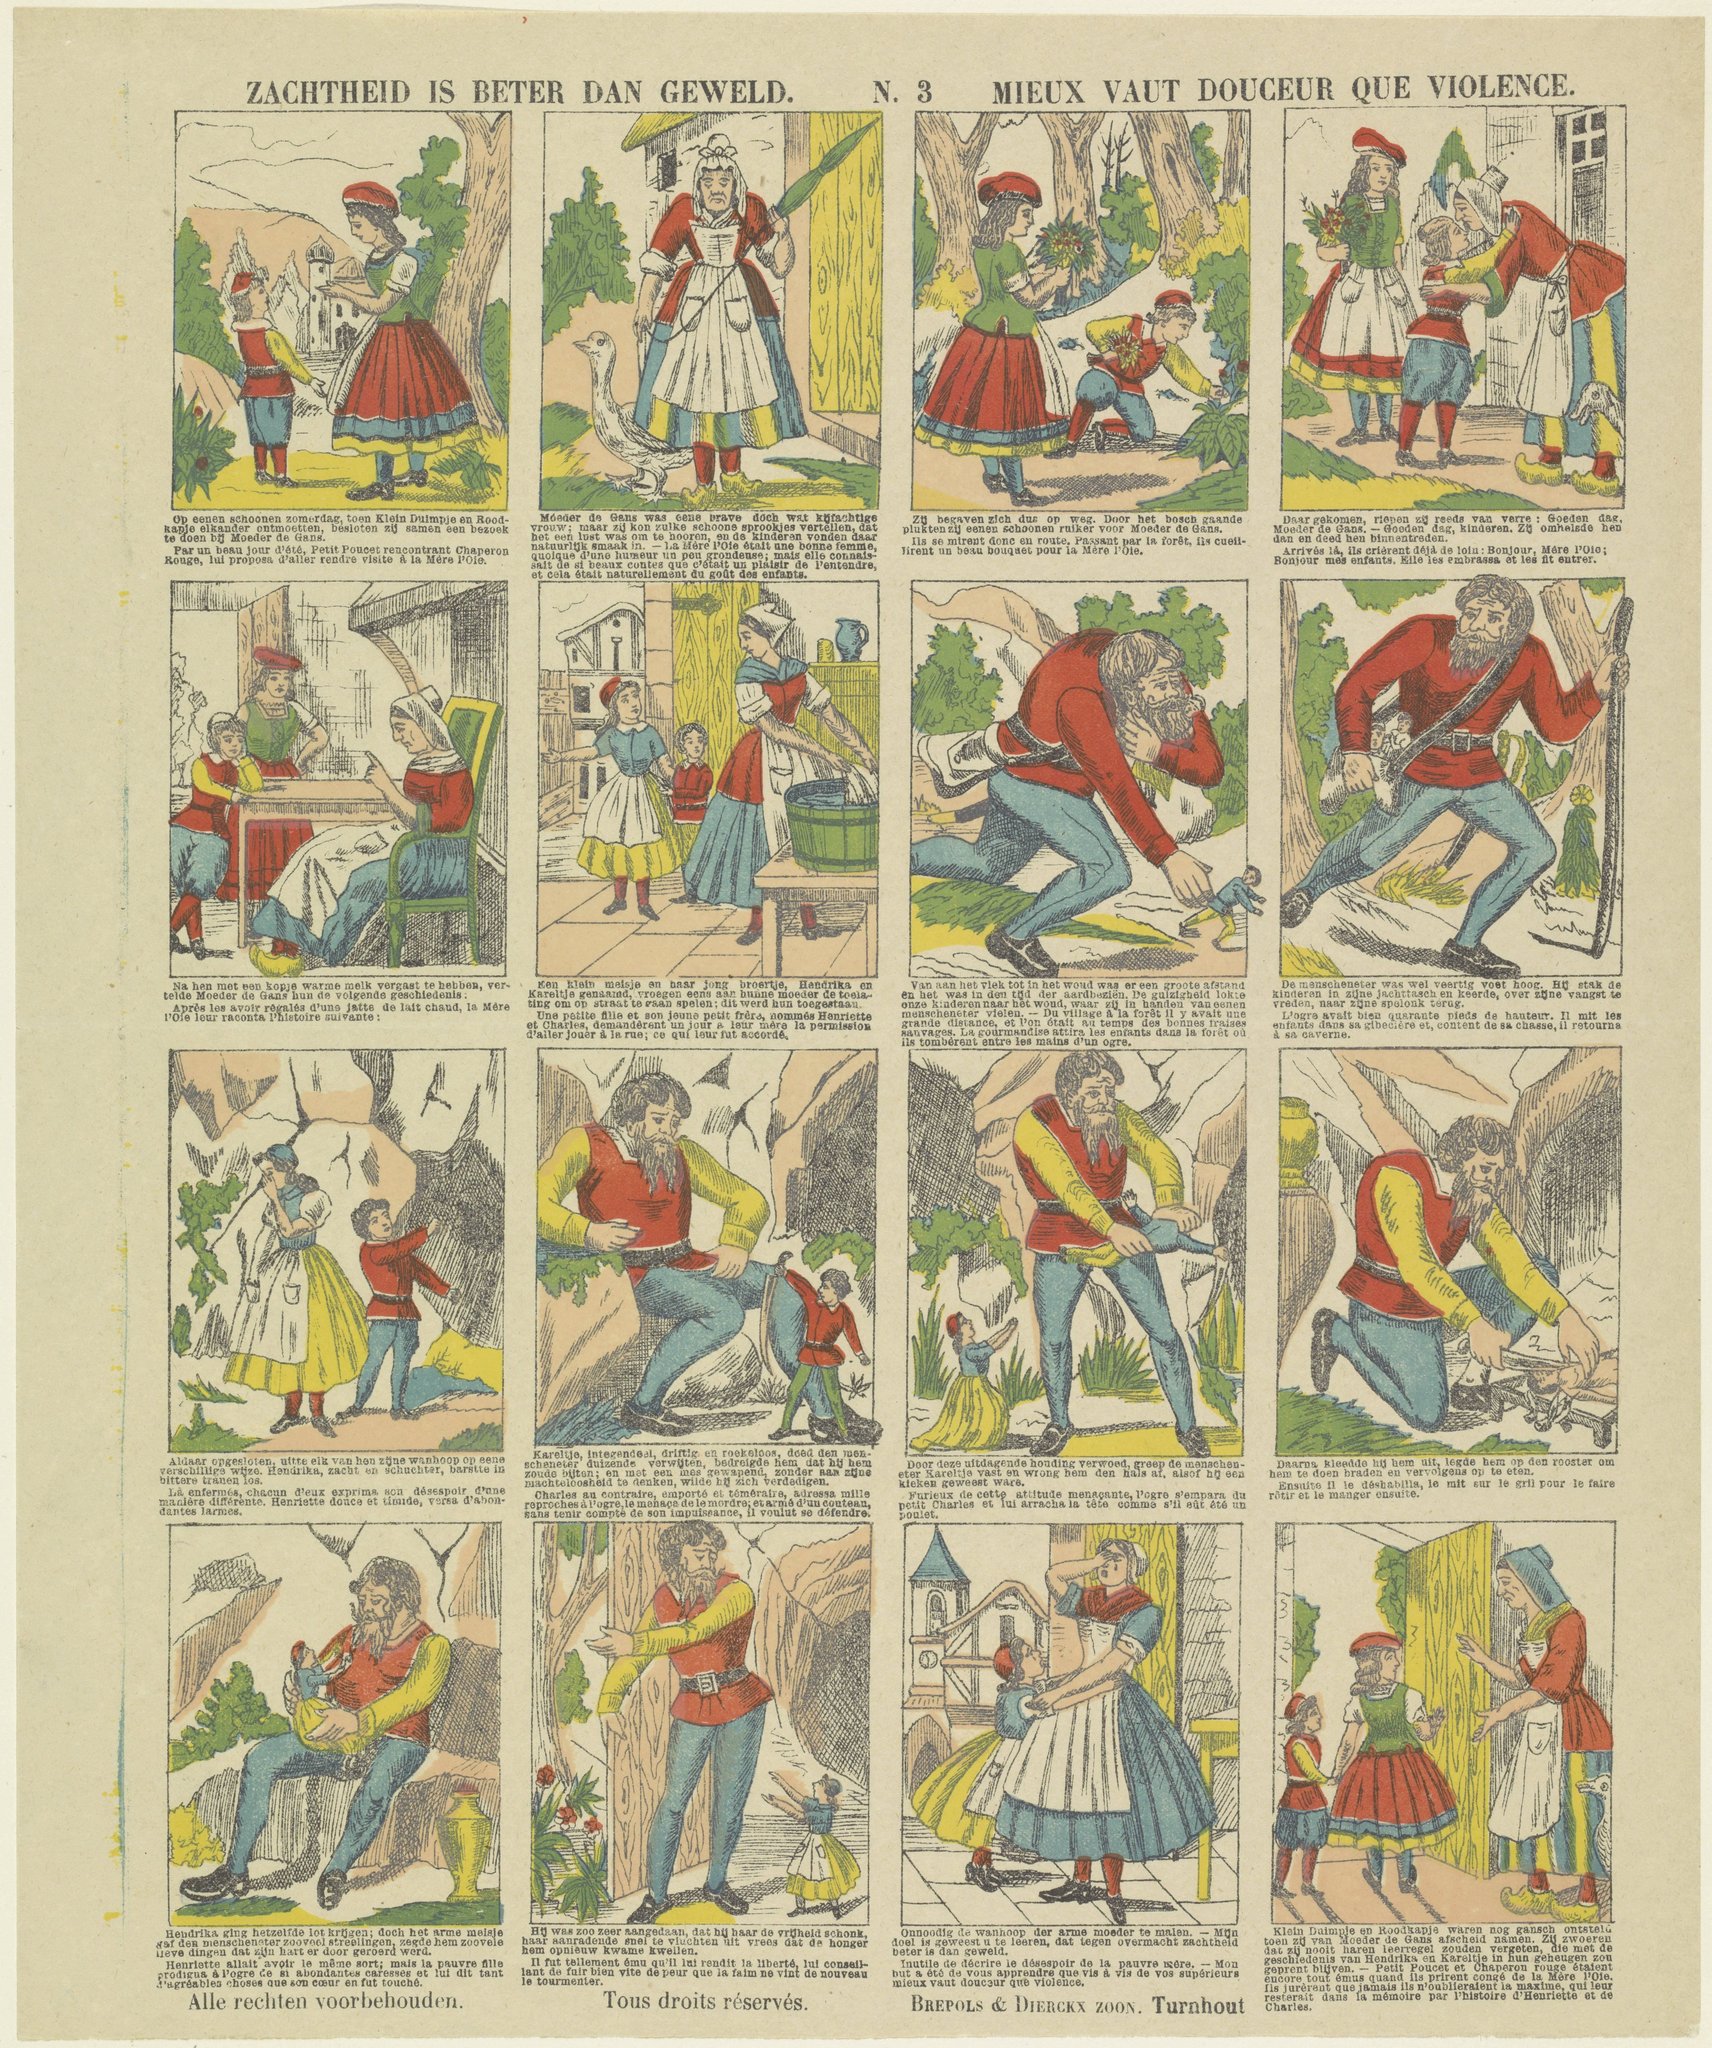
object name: print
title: Zachtheid is beter dan geweld / Mieux vaut douceur que violence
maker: Anonymous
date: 1833-1911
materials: paper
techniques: lithograph, letterpress printing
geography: turnhout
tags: tales and fairy tales, tales and fairy tales: little red riding-hood, cannibalism, tales and fairy tales: little thumbling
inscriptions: collector's mark: Lugt 2760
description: Blad met 16 voorstellingen over Moeder Gans die Roodkapje en Klein Duimpje een verhaal over een mensenetende reus verteld. Onder elke afbeelding een onderschrift in het Nederlands en in het Frans. Genummerd midden boven: N. 3.